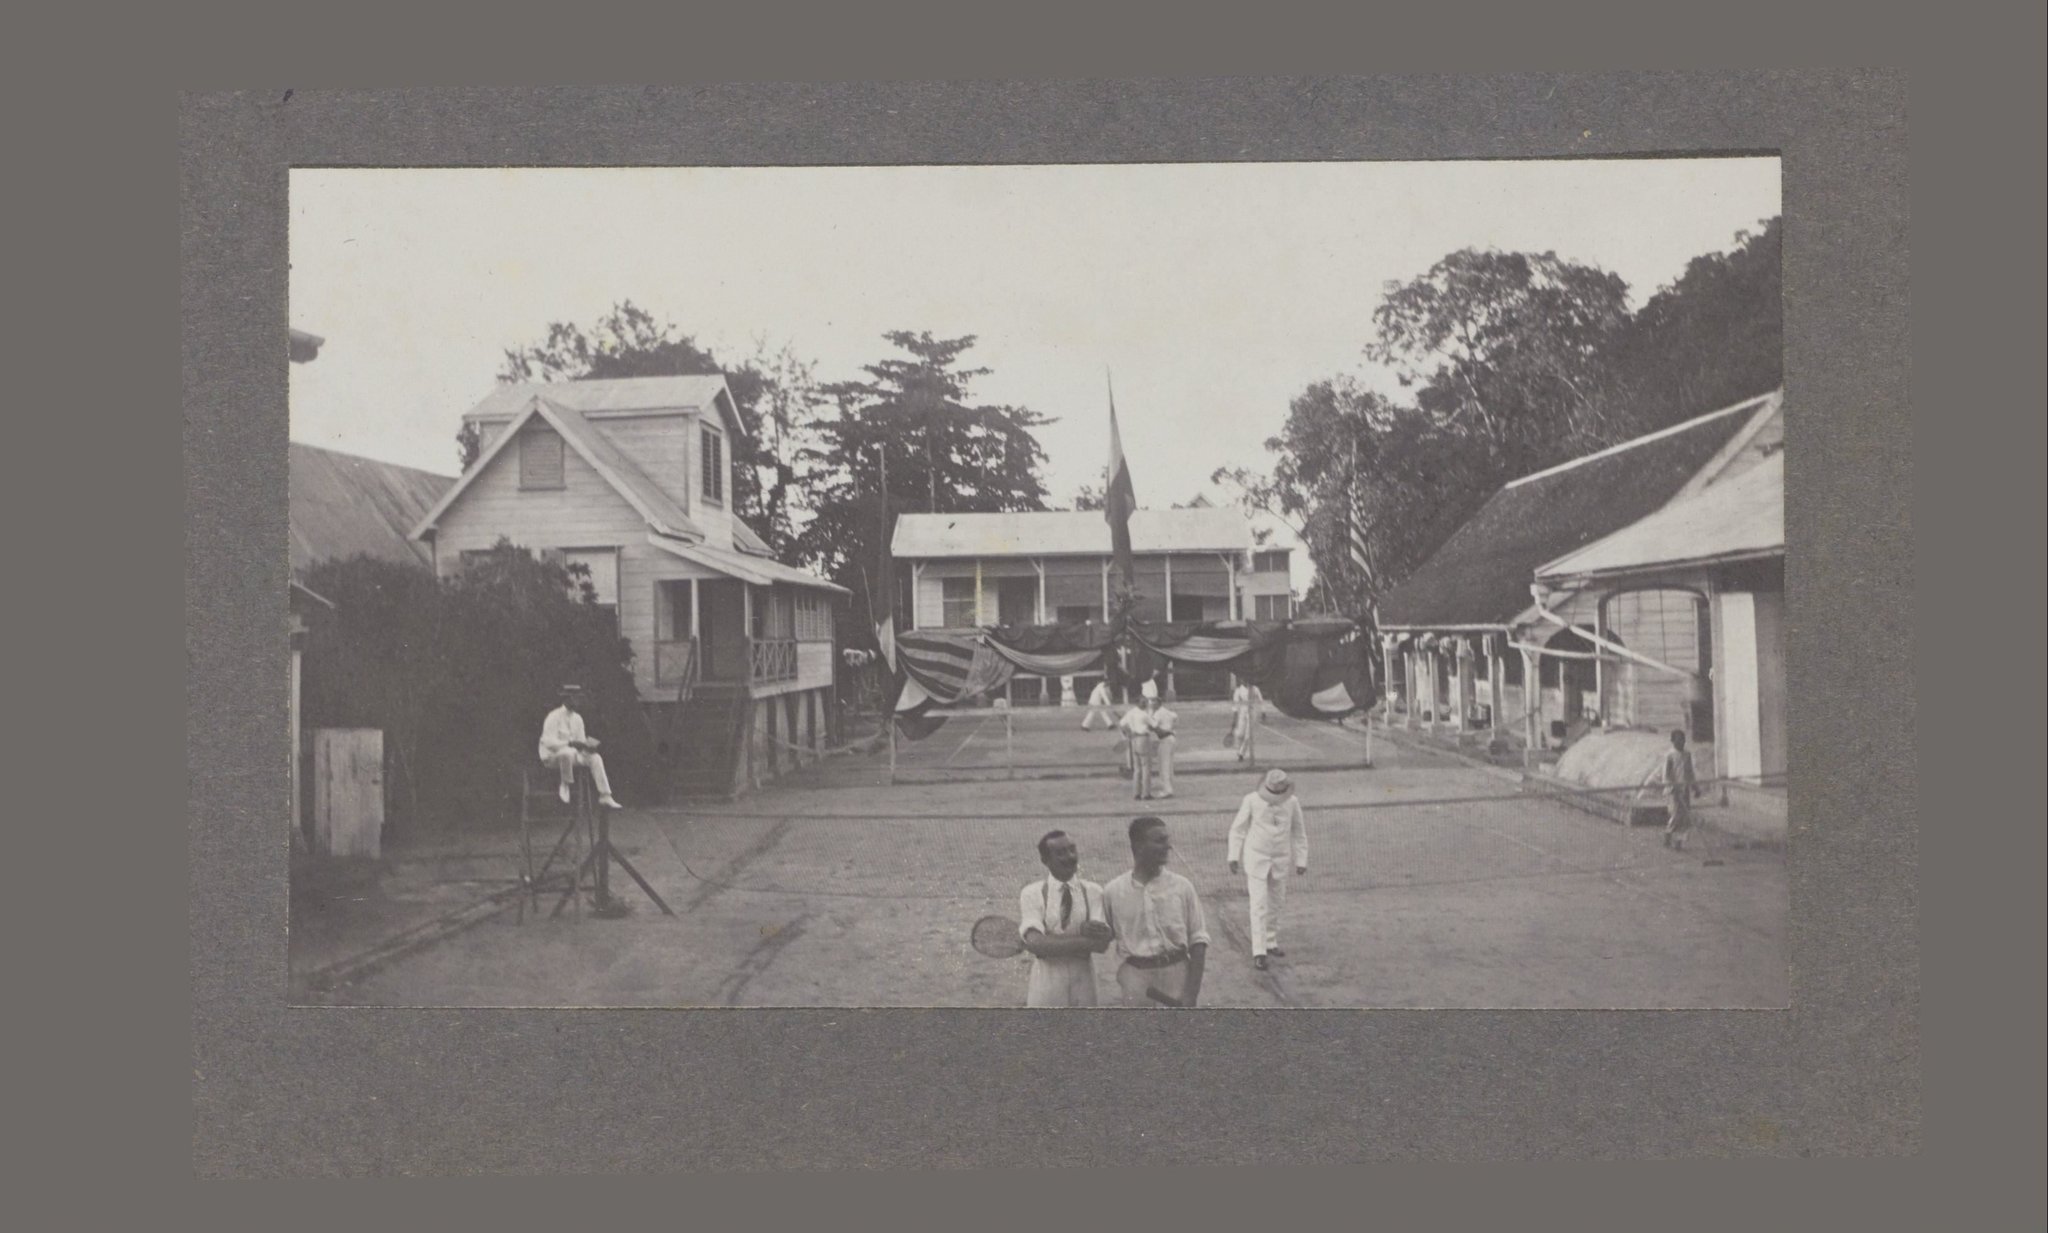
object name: photograph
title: Tennismatch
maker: Anonymous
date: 1907-1912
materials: photographic support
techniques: photography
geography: paramaribo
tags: tennis, lawn-tennis, suriname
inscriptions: inscription: ‘Op de tennisbaan tijdens de matches met de officieren v H. M. Zeeland. Juli 1912’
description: Tenniswedstrijd met de officieren van het Pantserdekschip Hr. Ms. Zeeland op de tennisclub in Paramaribo, juli 1912. Onderdeel van het fotoalbum over het leven van de familie Gonggrijp in Suriname rond 1912.